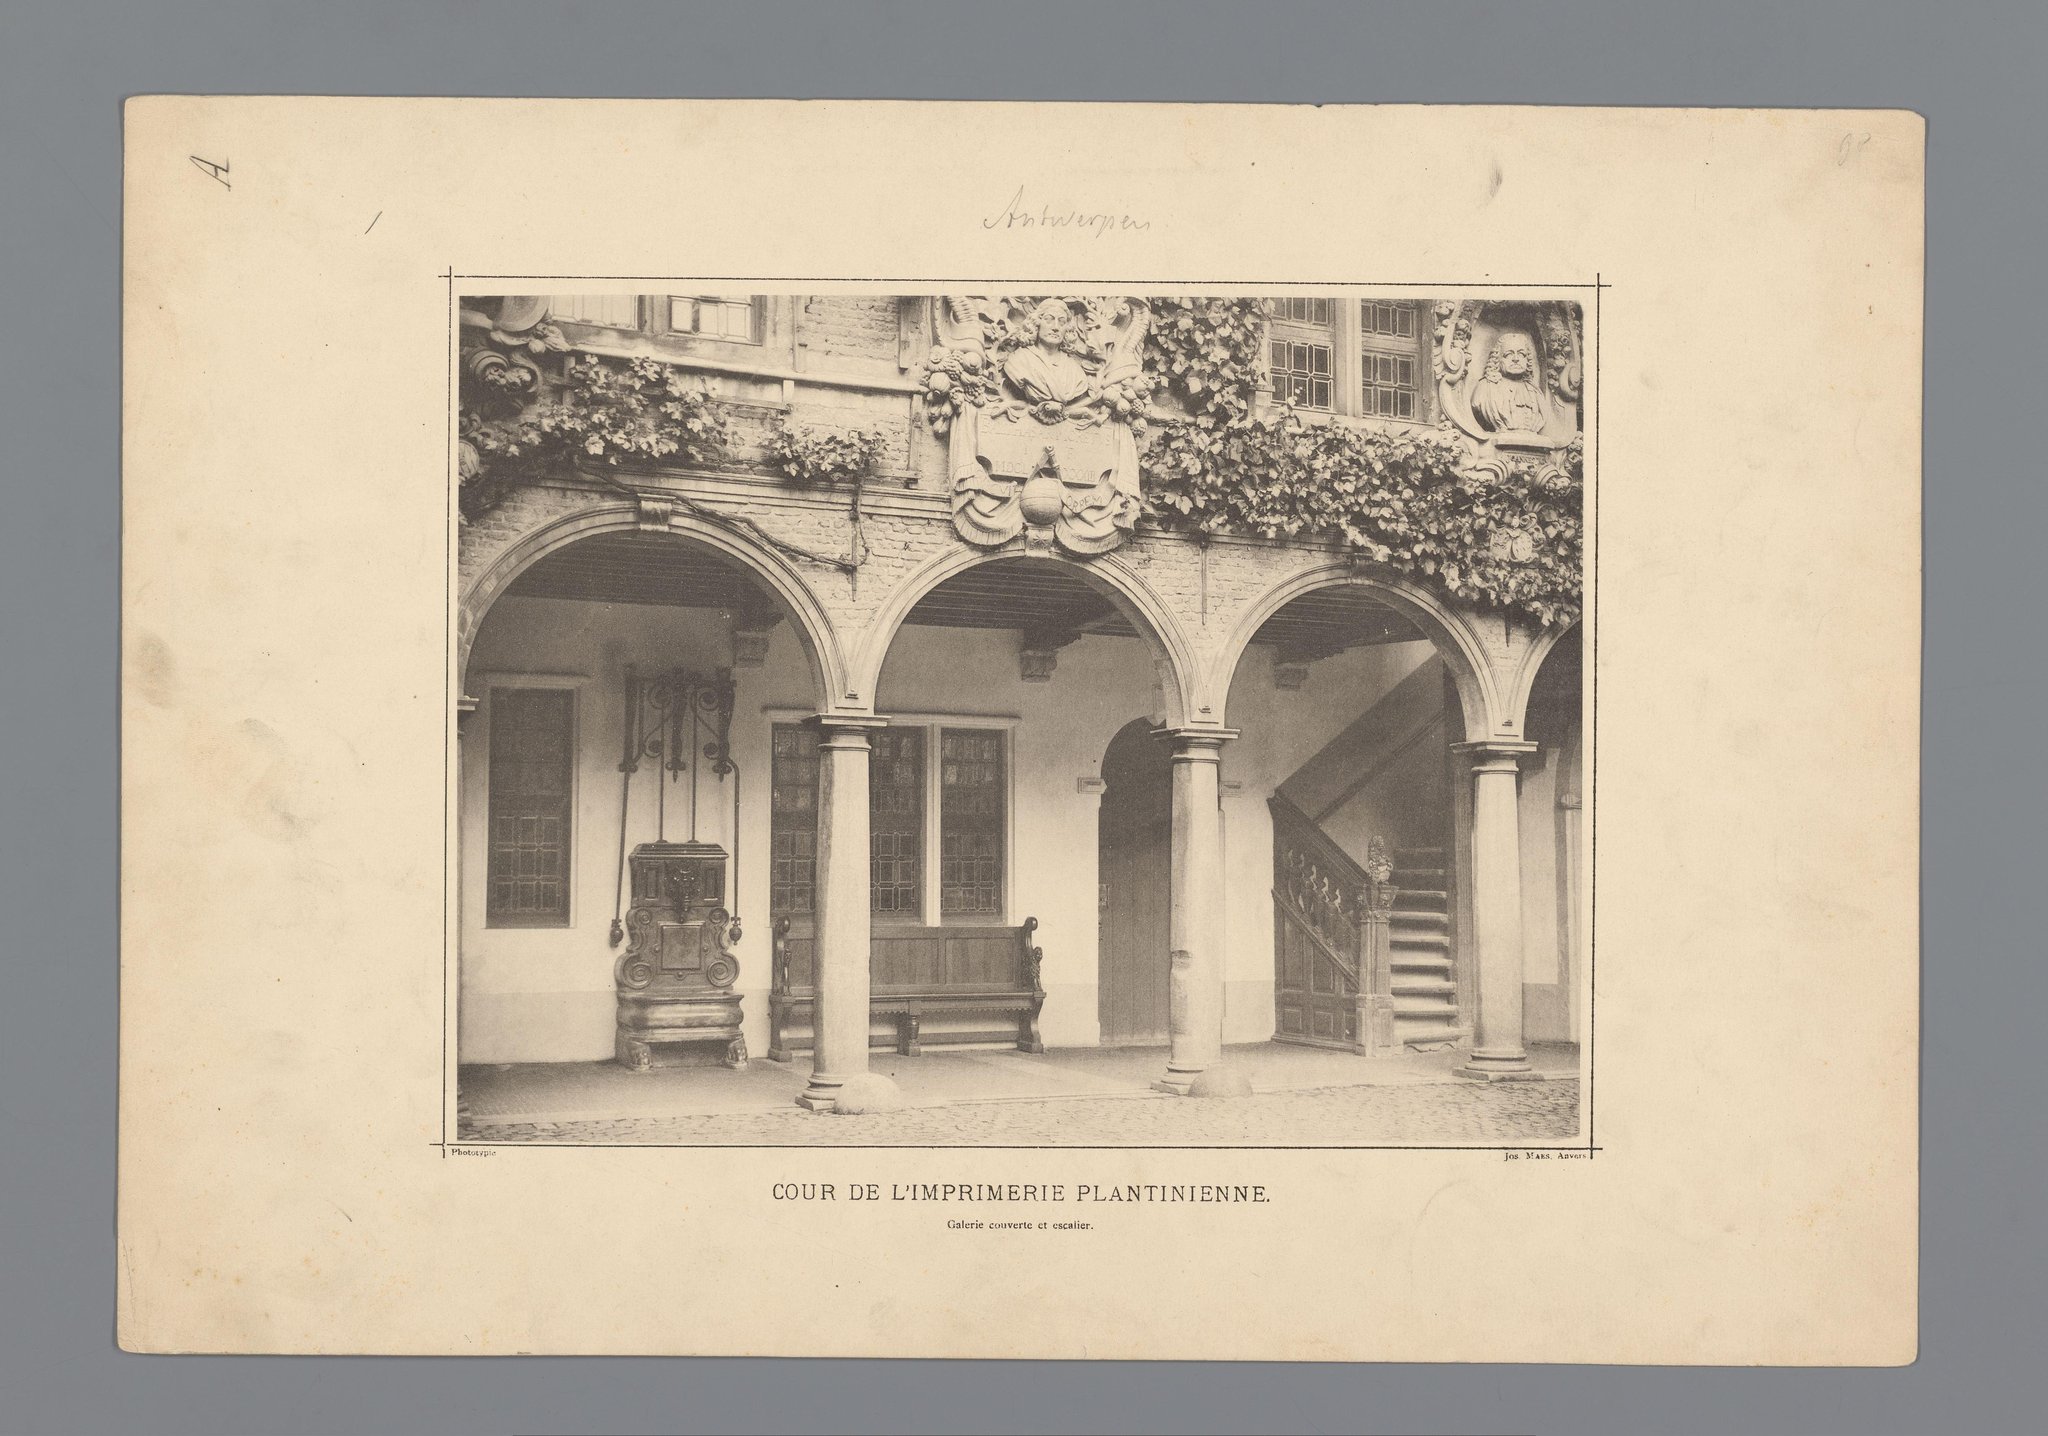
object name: photomechanical print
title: Gezichten op drukkerij Plantijn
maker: joseph maes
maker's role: fotograaf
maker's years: 1838-1908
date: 1848-1908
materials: paper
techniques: photograph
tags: printing, printing office, antwerp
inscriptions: collector's mark: Lugt 3937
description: Drukkerij Plantijn was de drukkerij en het woonhuis van uitgeversfamilie Plantin-Moretus, huidig Museum Plantin-Moretus.